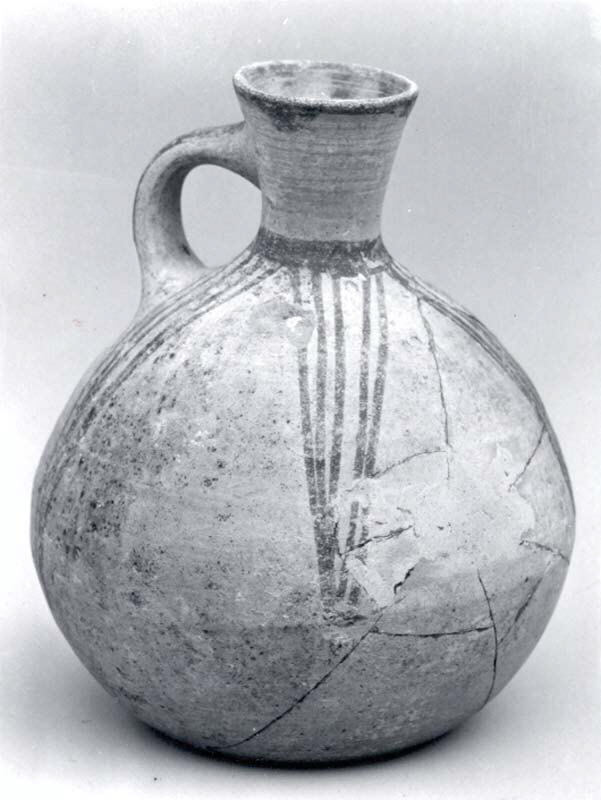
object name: jug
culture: iranian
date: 900-700 BCE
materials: ceramic, paint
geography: iran